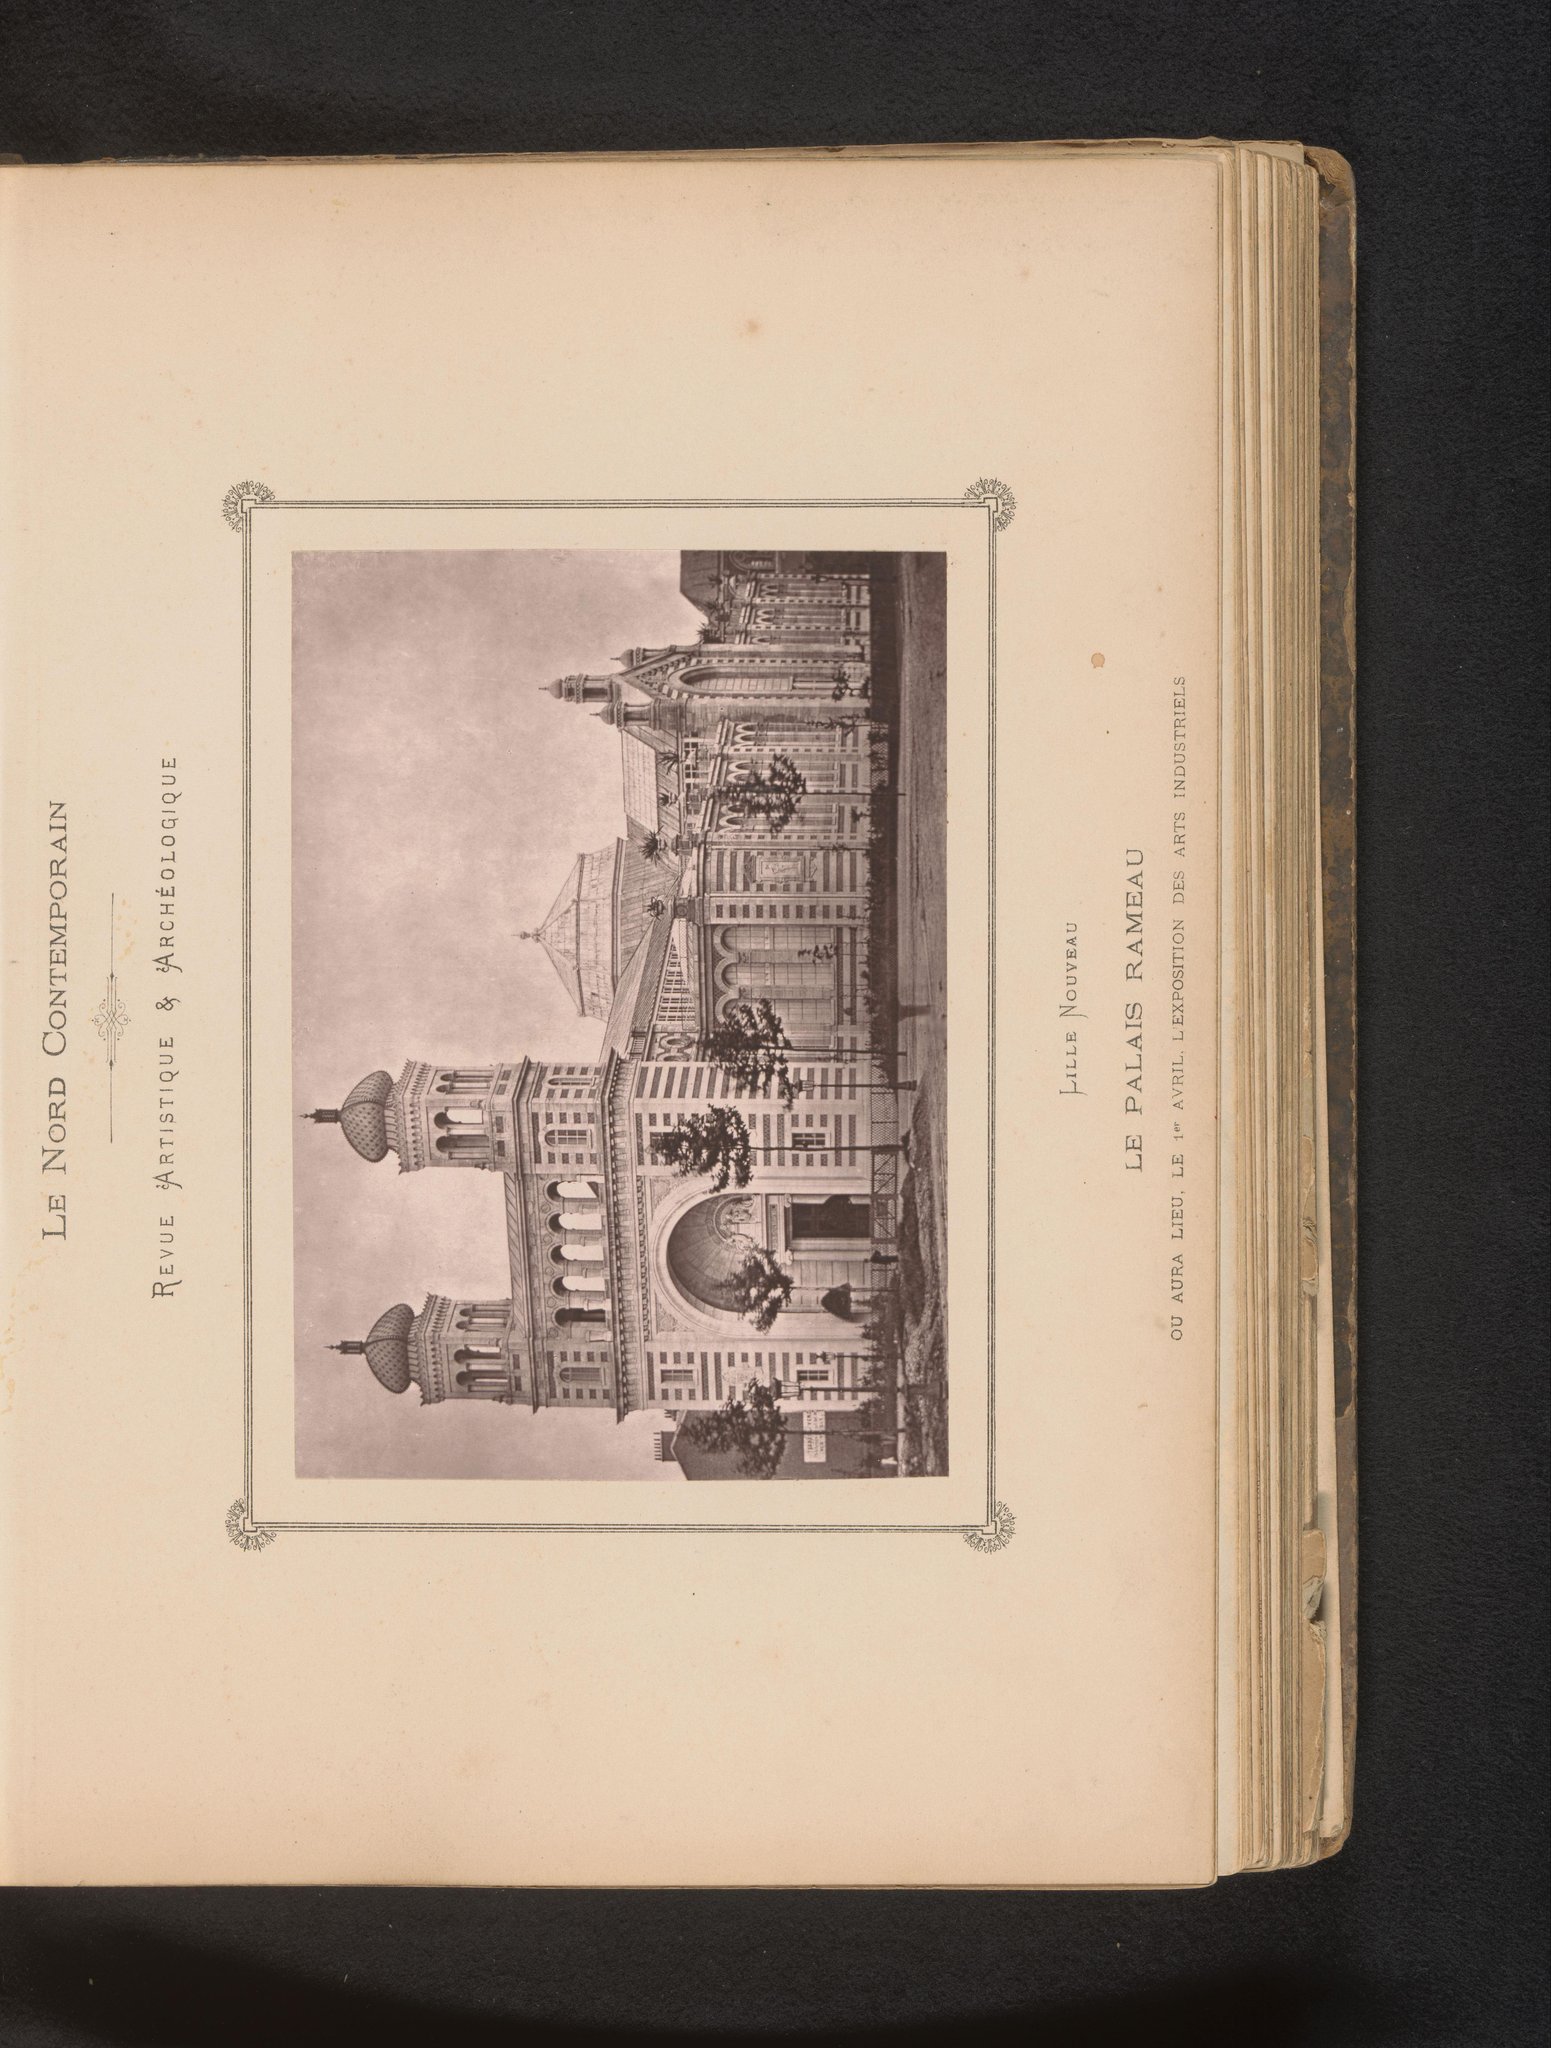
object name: page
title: Lille Nouveau, Le Palais Rameau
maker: Anonymous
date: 1878-1882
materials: paper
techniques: woodburytype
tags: palace, lille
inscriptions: inscription: ‘Le Nord Contemporain/ Revue Artistique & Archéologique’, inscription: ‘Ou aura Lieu, le 1er avril, l'exposition des arts industriels’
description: Prent op derde ongenummerde pagina na pagina 96.